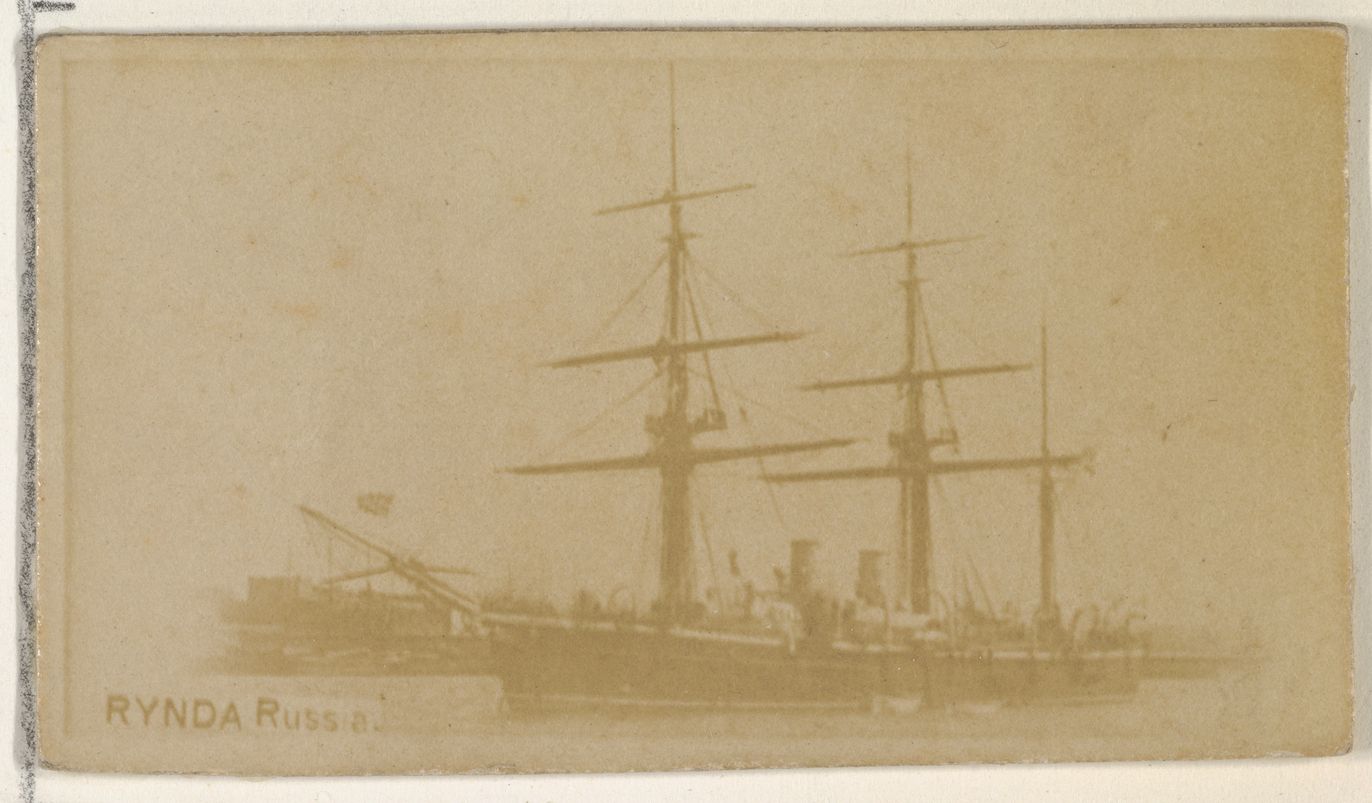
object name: photograph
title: Rynda, Russia, from the Famous Ships series (N50) for Virginia Brights Cigarettes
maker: allen & ginter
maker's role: publisher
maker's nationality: american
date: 1895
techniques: albumen silver print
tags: ships